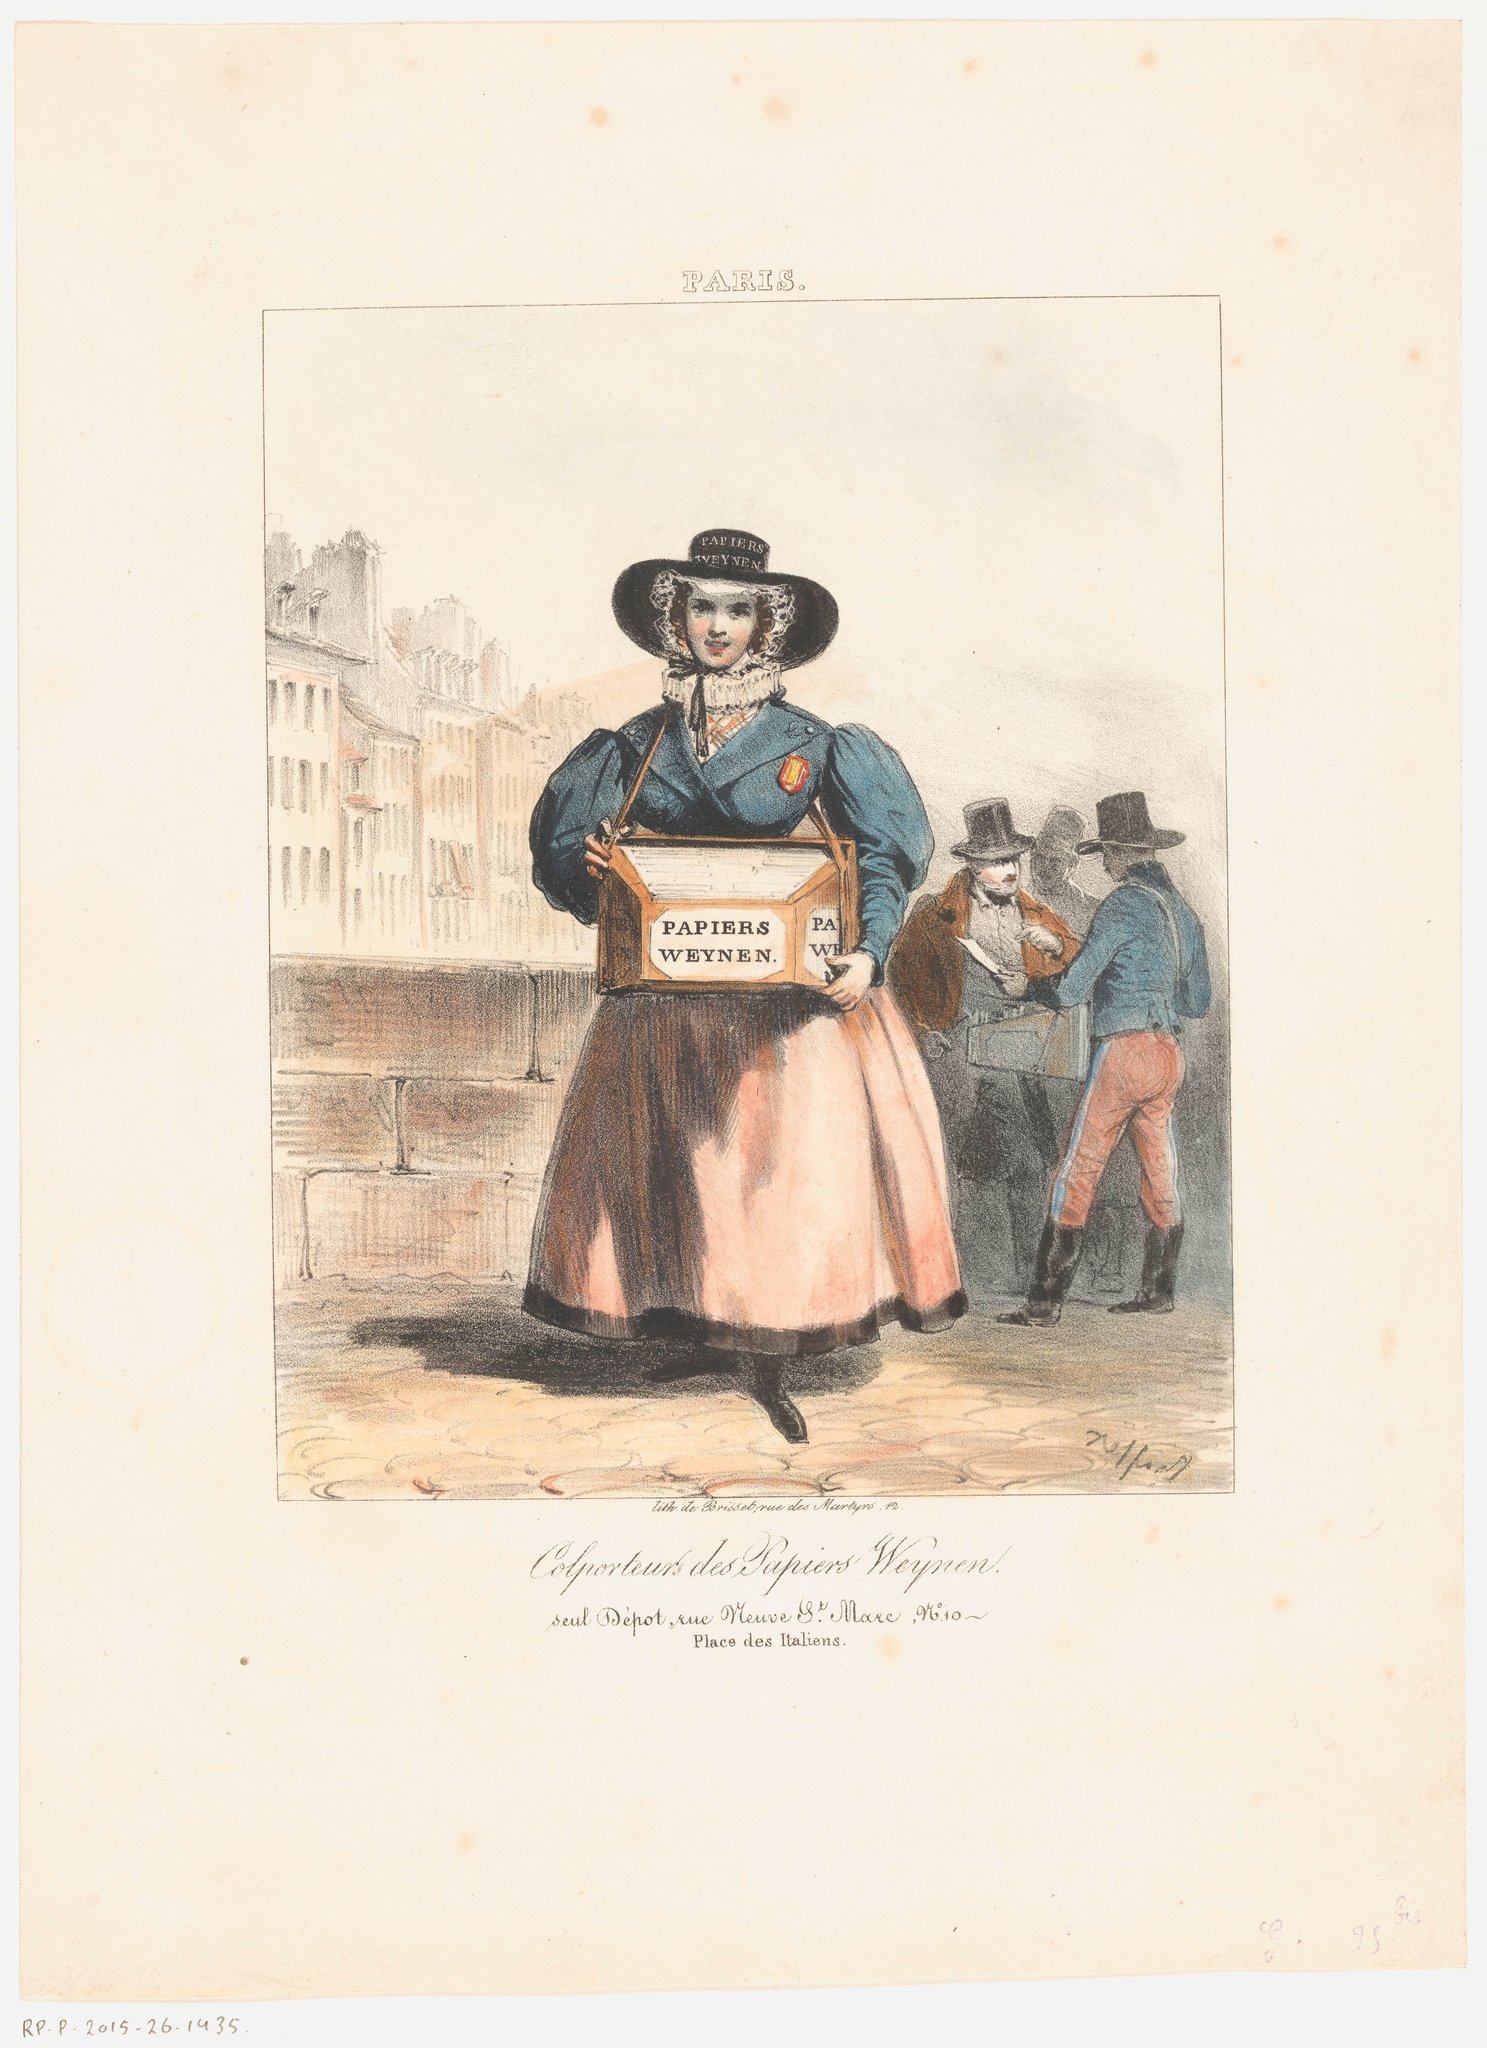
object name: print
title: Straatverkoopster van Weynen papier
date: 1833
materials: paper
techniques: hand coloring, lithograph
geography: paris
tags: street-trader, paper (writing material), paris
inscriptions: collector's mark: Lugt 4779, collector's mark: Lugt 2228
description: Op een brug staat een vrouw met een hoed en een doos voor haar buik. Op haar hoed en op de doos staat 'Papiers Weynen'. In de achtergrond verkoopt haar mannelijke collega papier aan twee heren.